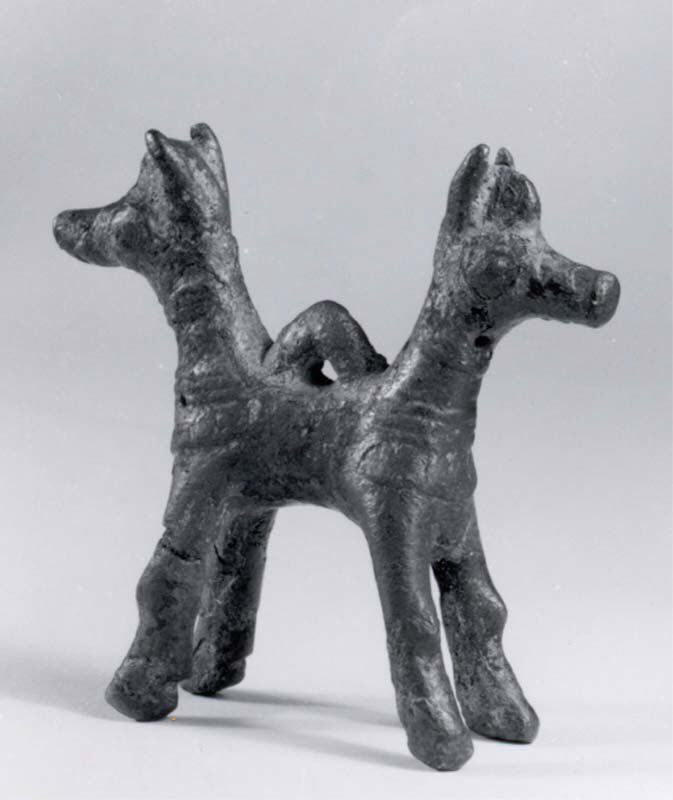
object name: pendant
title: Pendant in the form of two addorsed horses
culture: iranian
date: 1000-1 BCE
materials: bronze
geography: western iran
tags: horses